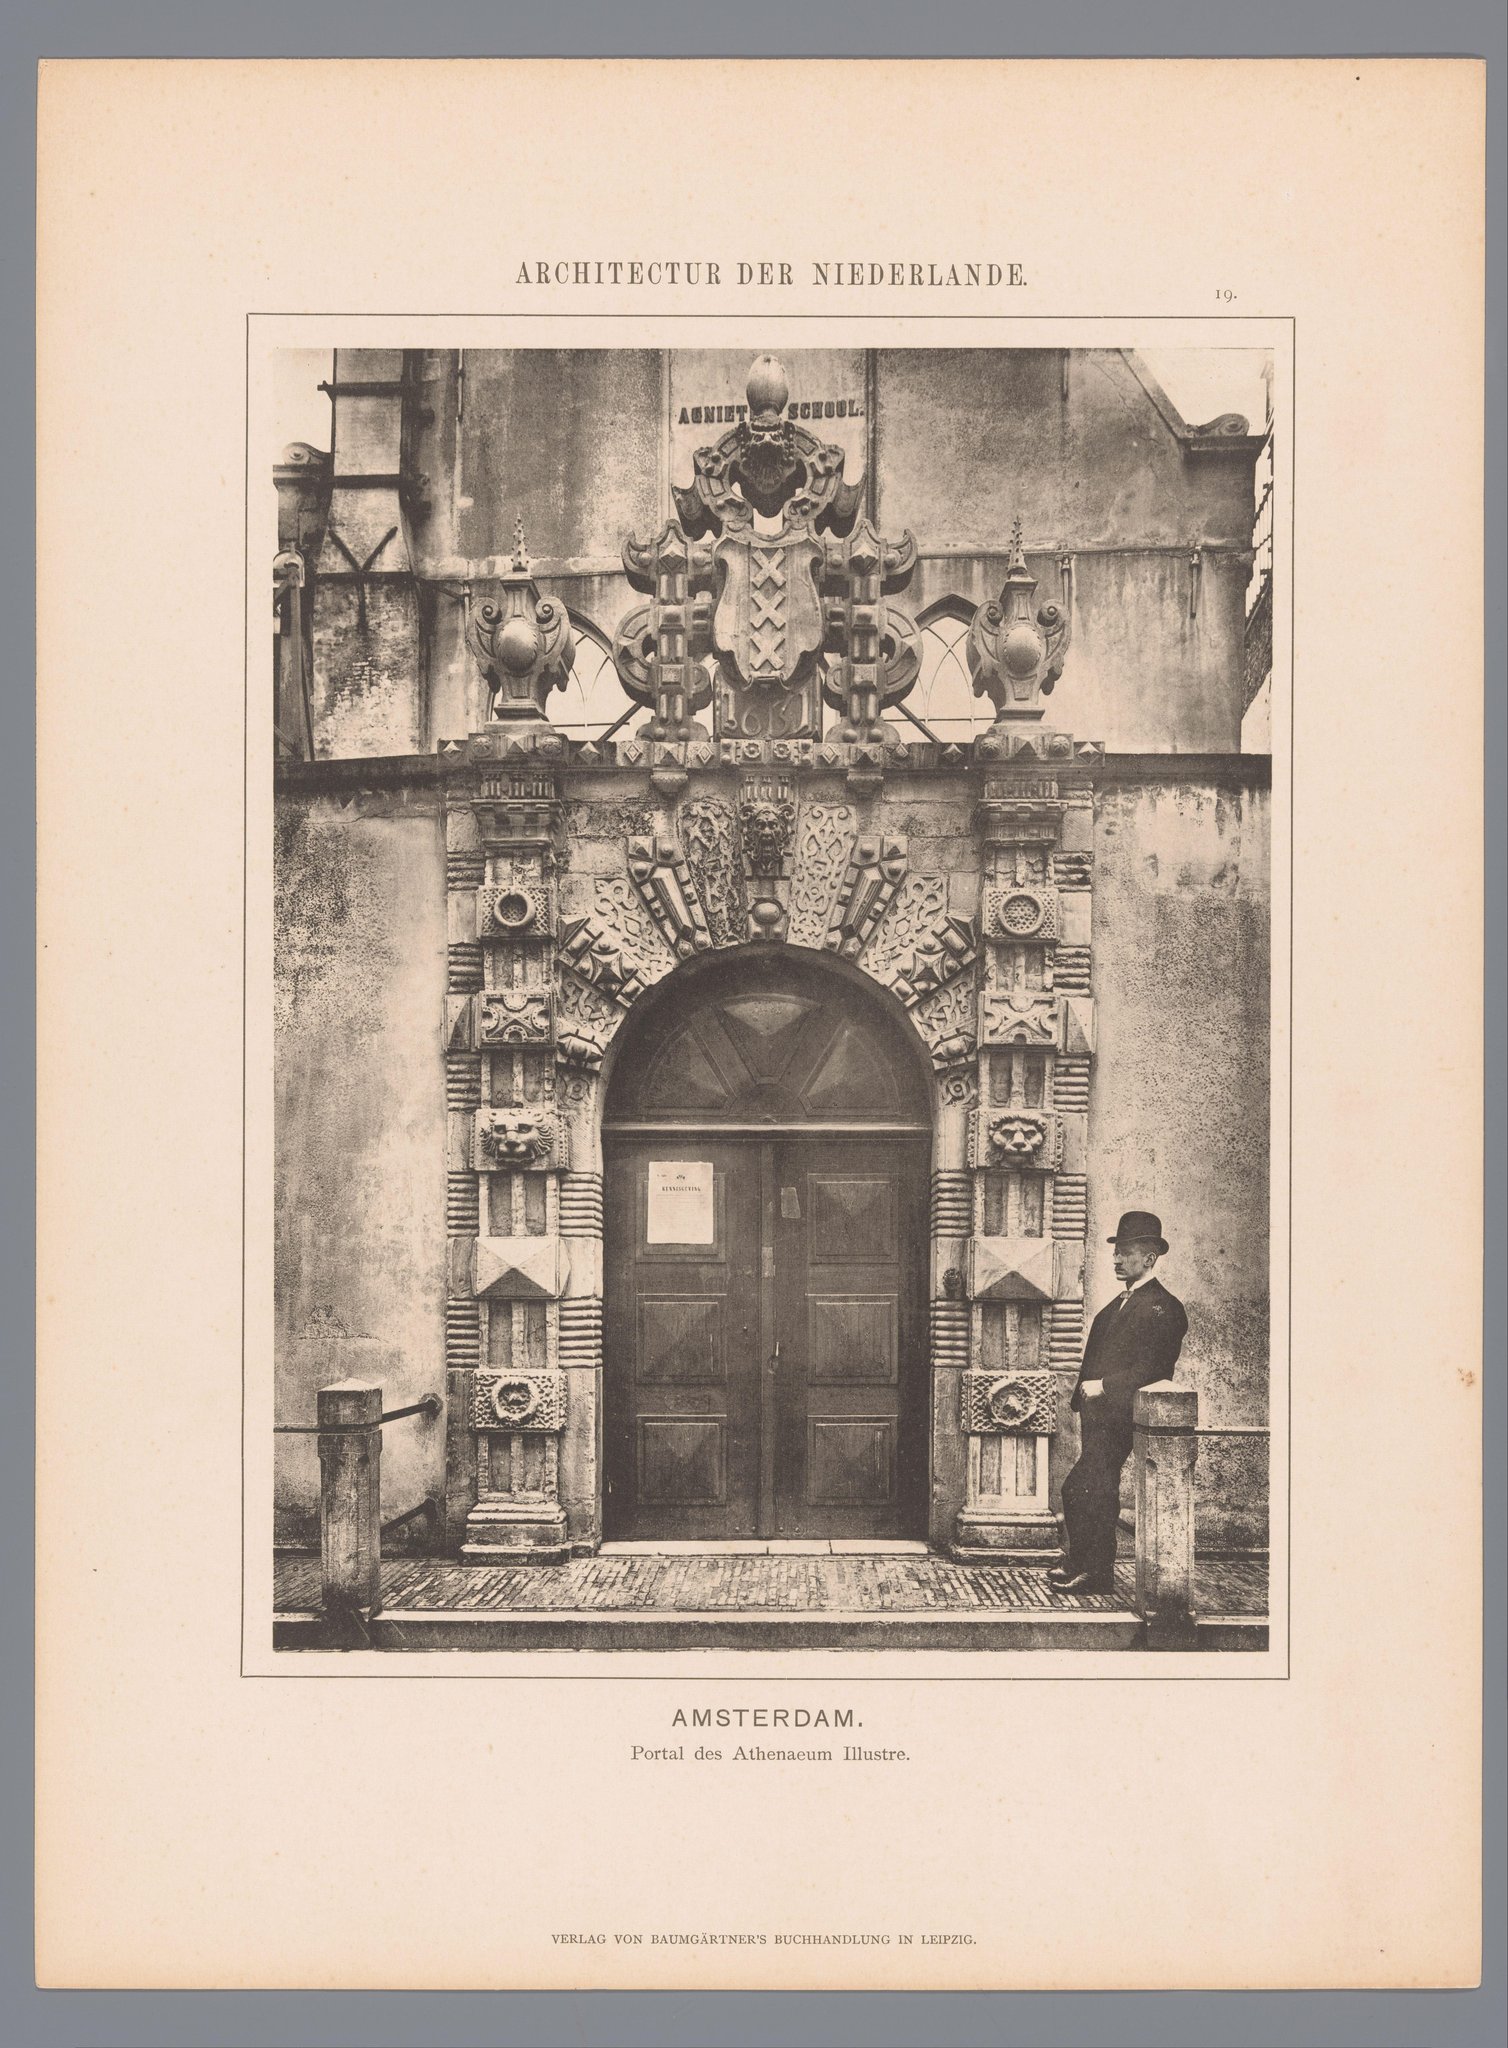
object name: book illustration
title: Architectuur in Nederland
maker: Anonymous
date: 1894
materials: paper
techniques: photograph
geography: leipzig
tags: secondary education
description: Afdruk uit: Krook, L. Architectur der Niederlande. Leipzig: Baumgärtner's Buchhandlung, 1894.